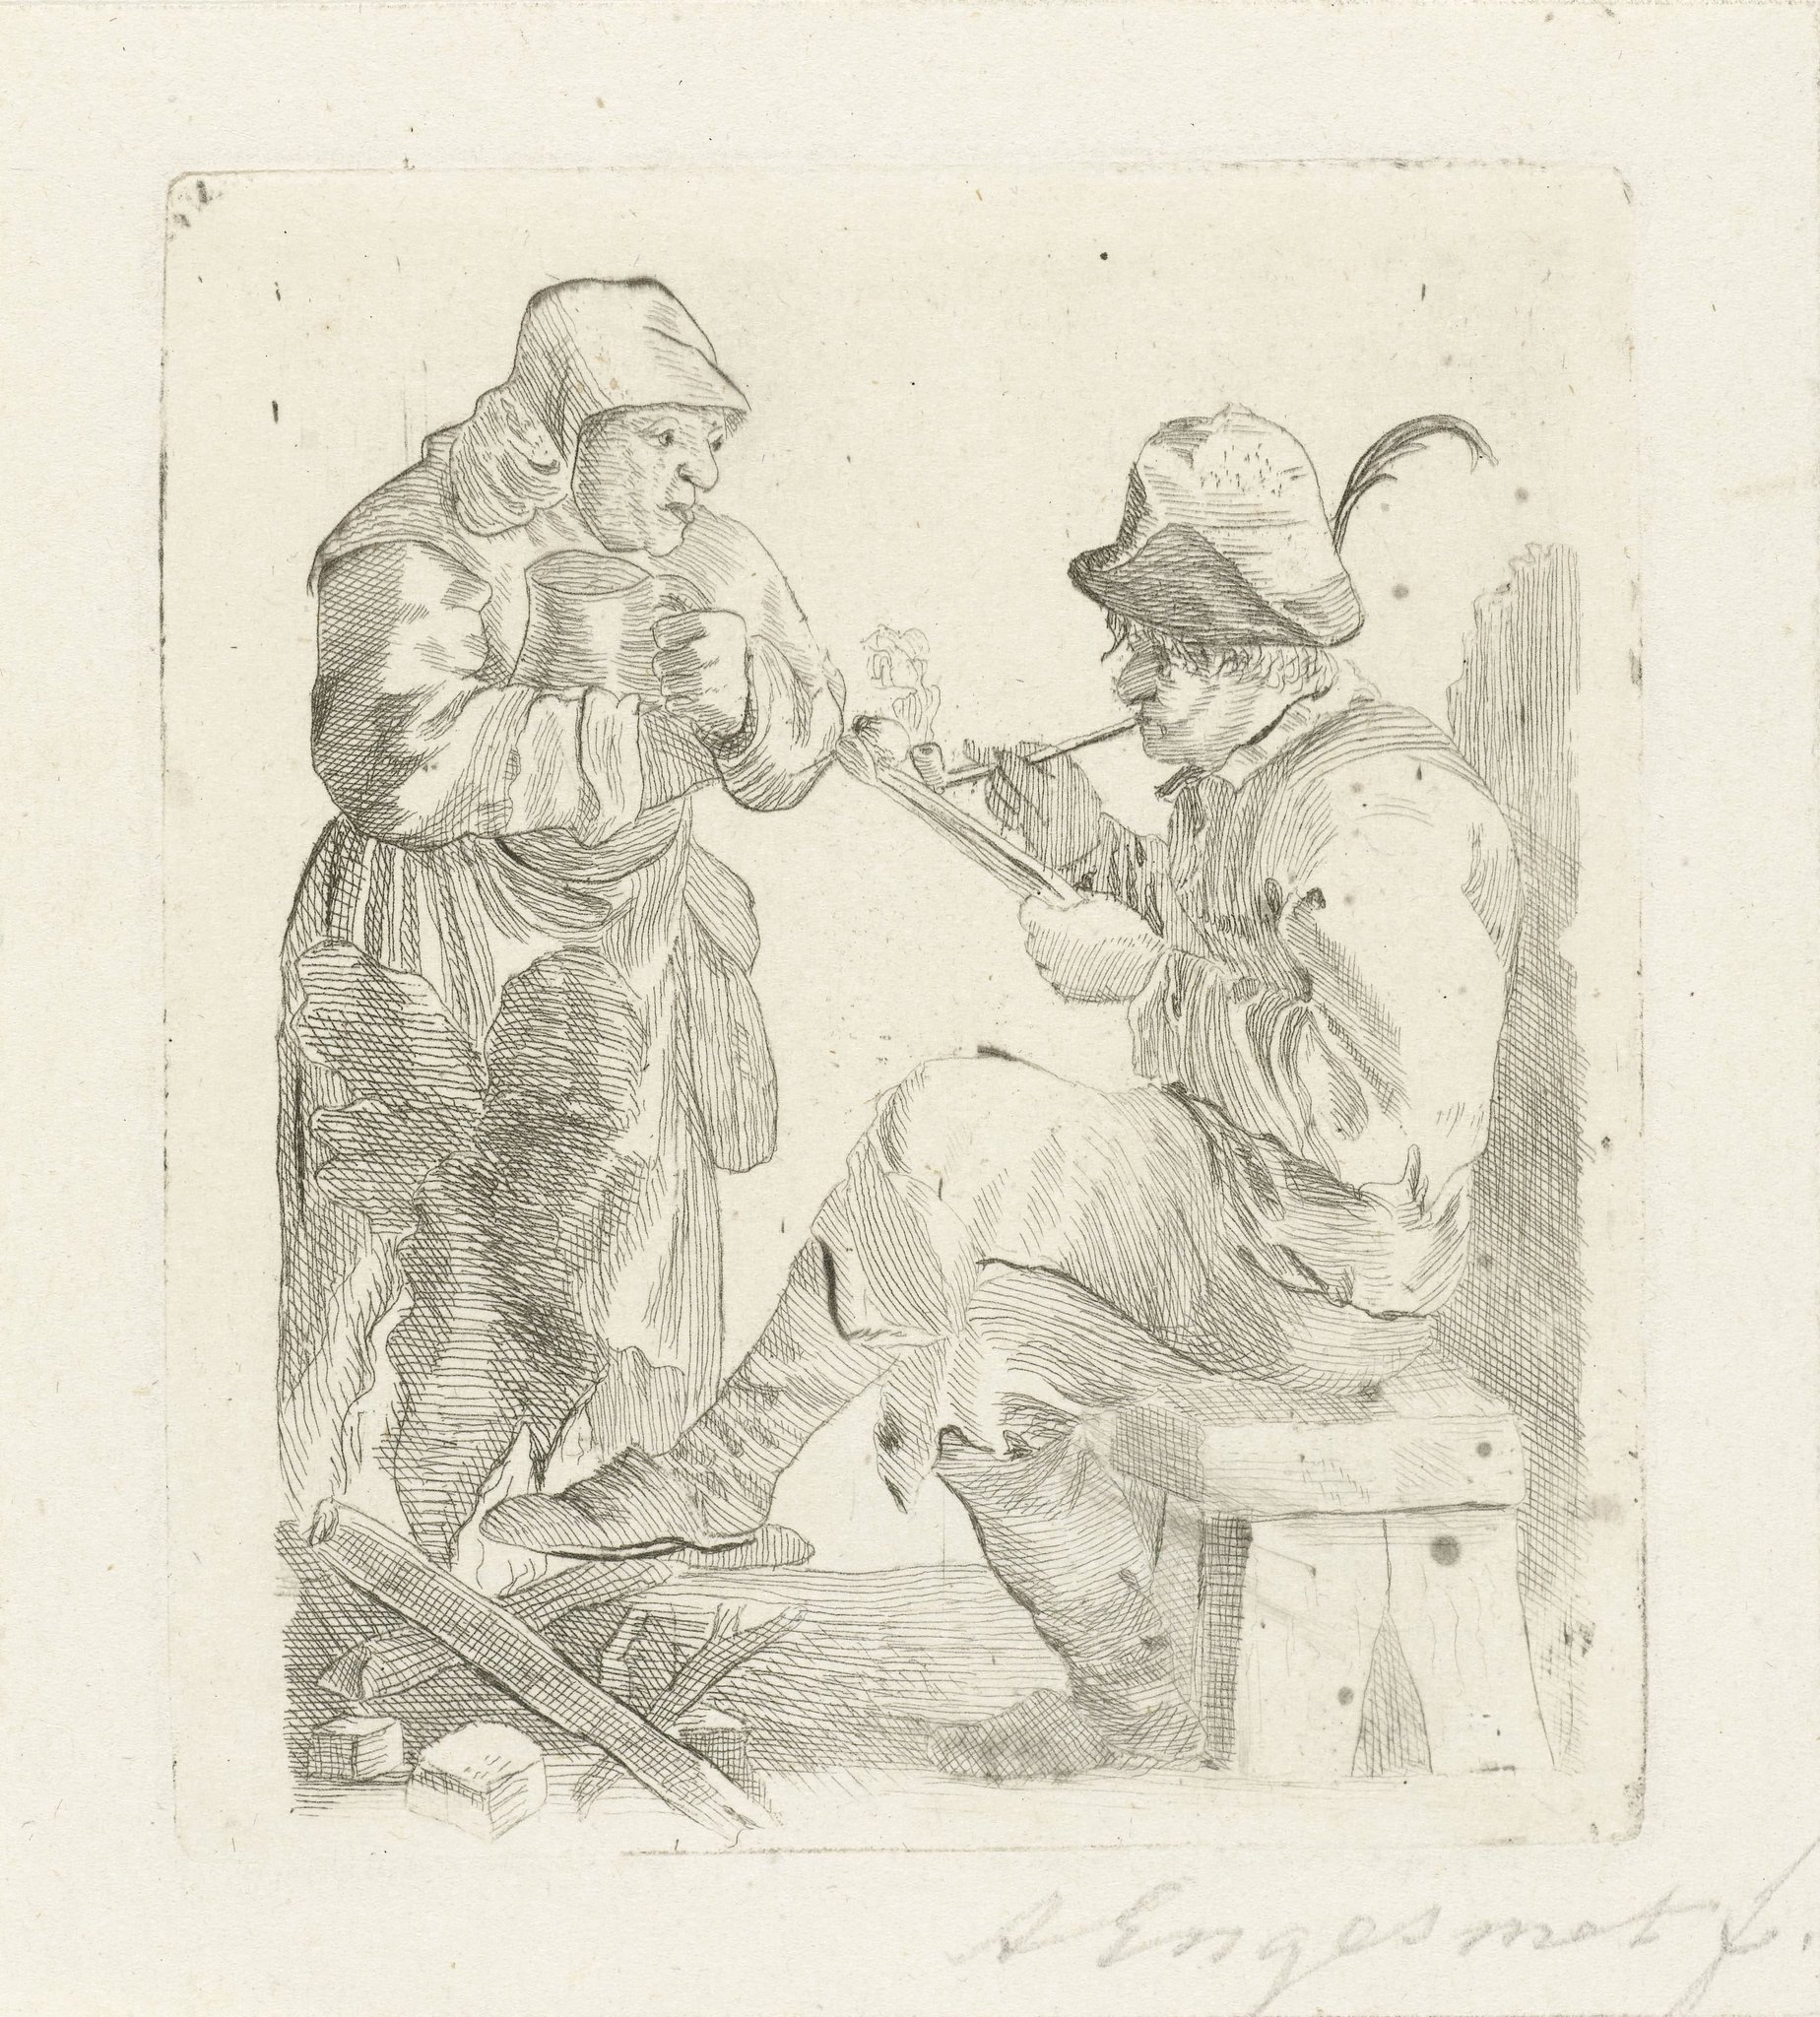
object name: print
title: Rokende man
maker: adalbertus engelsmet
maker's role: print maker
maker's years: 1792-1872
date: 1802-1872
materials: paper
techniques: etching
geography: haarlem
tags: pipe ~ tobacco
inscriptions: collector's mark: Lugt 2228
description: Een man met een hoed en pantoffels, steekt zijn pijp aan met een tussen een tang geklemd kooltje. Bij zijn voeten brandt een vuur. Naast hem staat een vrouw met een kan in haar armen.